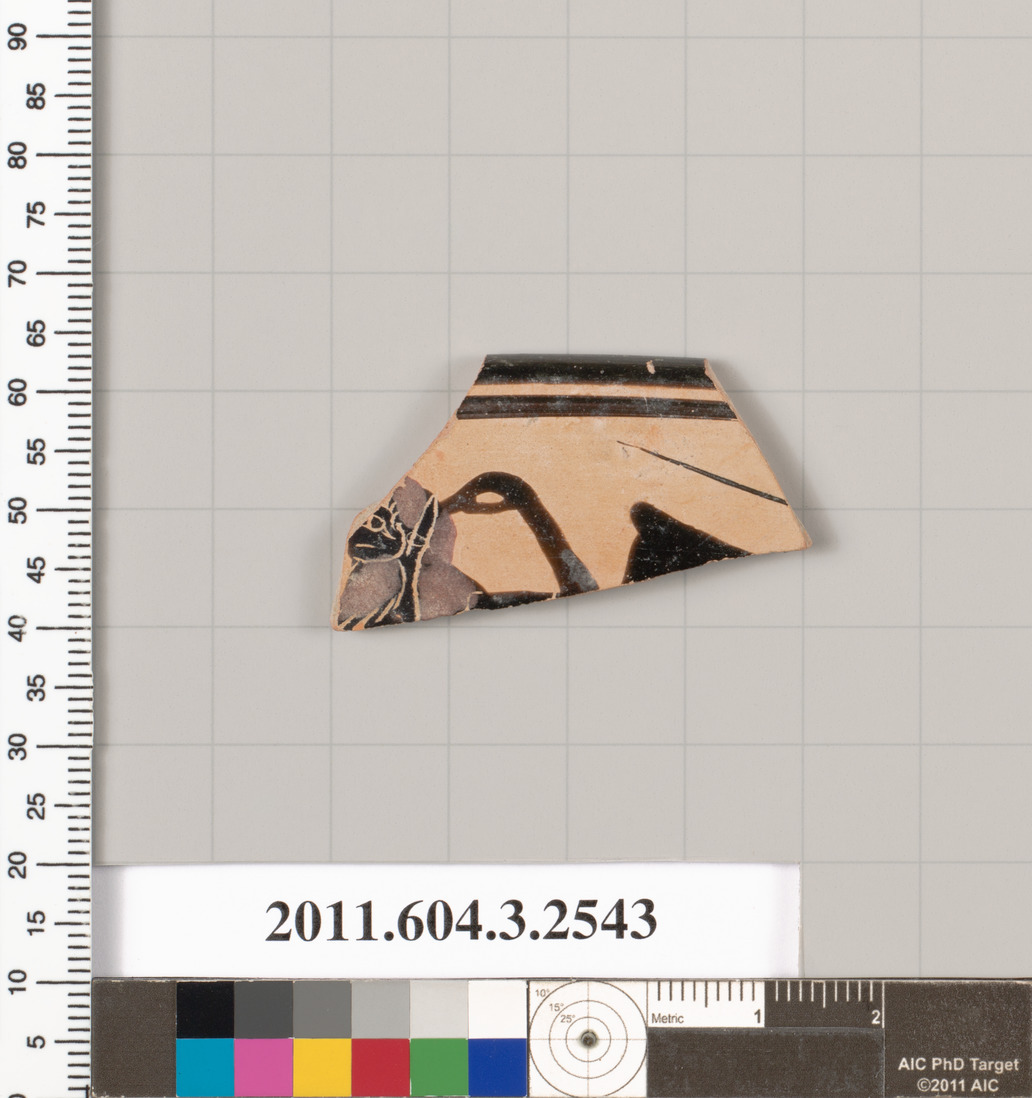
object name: kylix fragment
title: Terracotta rim fragment of a kylix: eye-cup (drinking cup)?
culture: greek, attic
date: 534-468 BCE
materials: terracotta